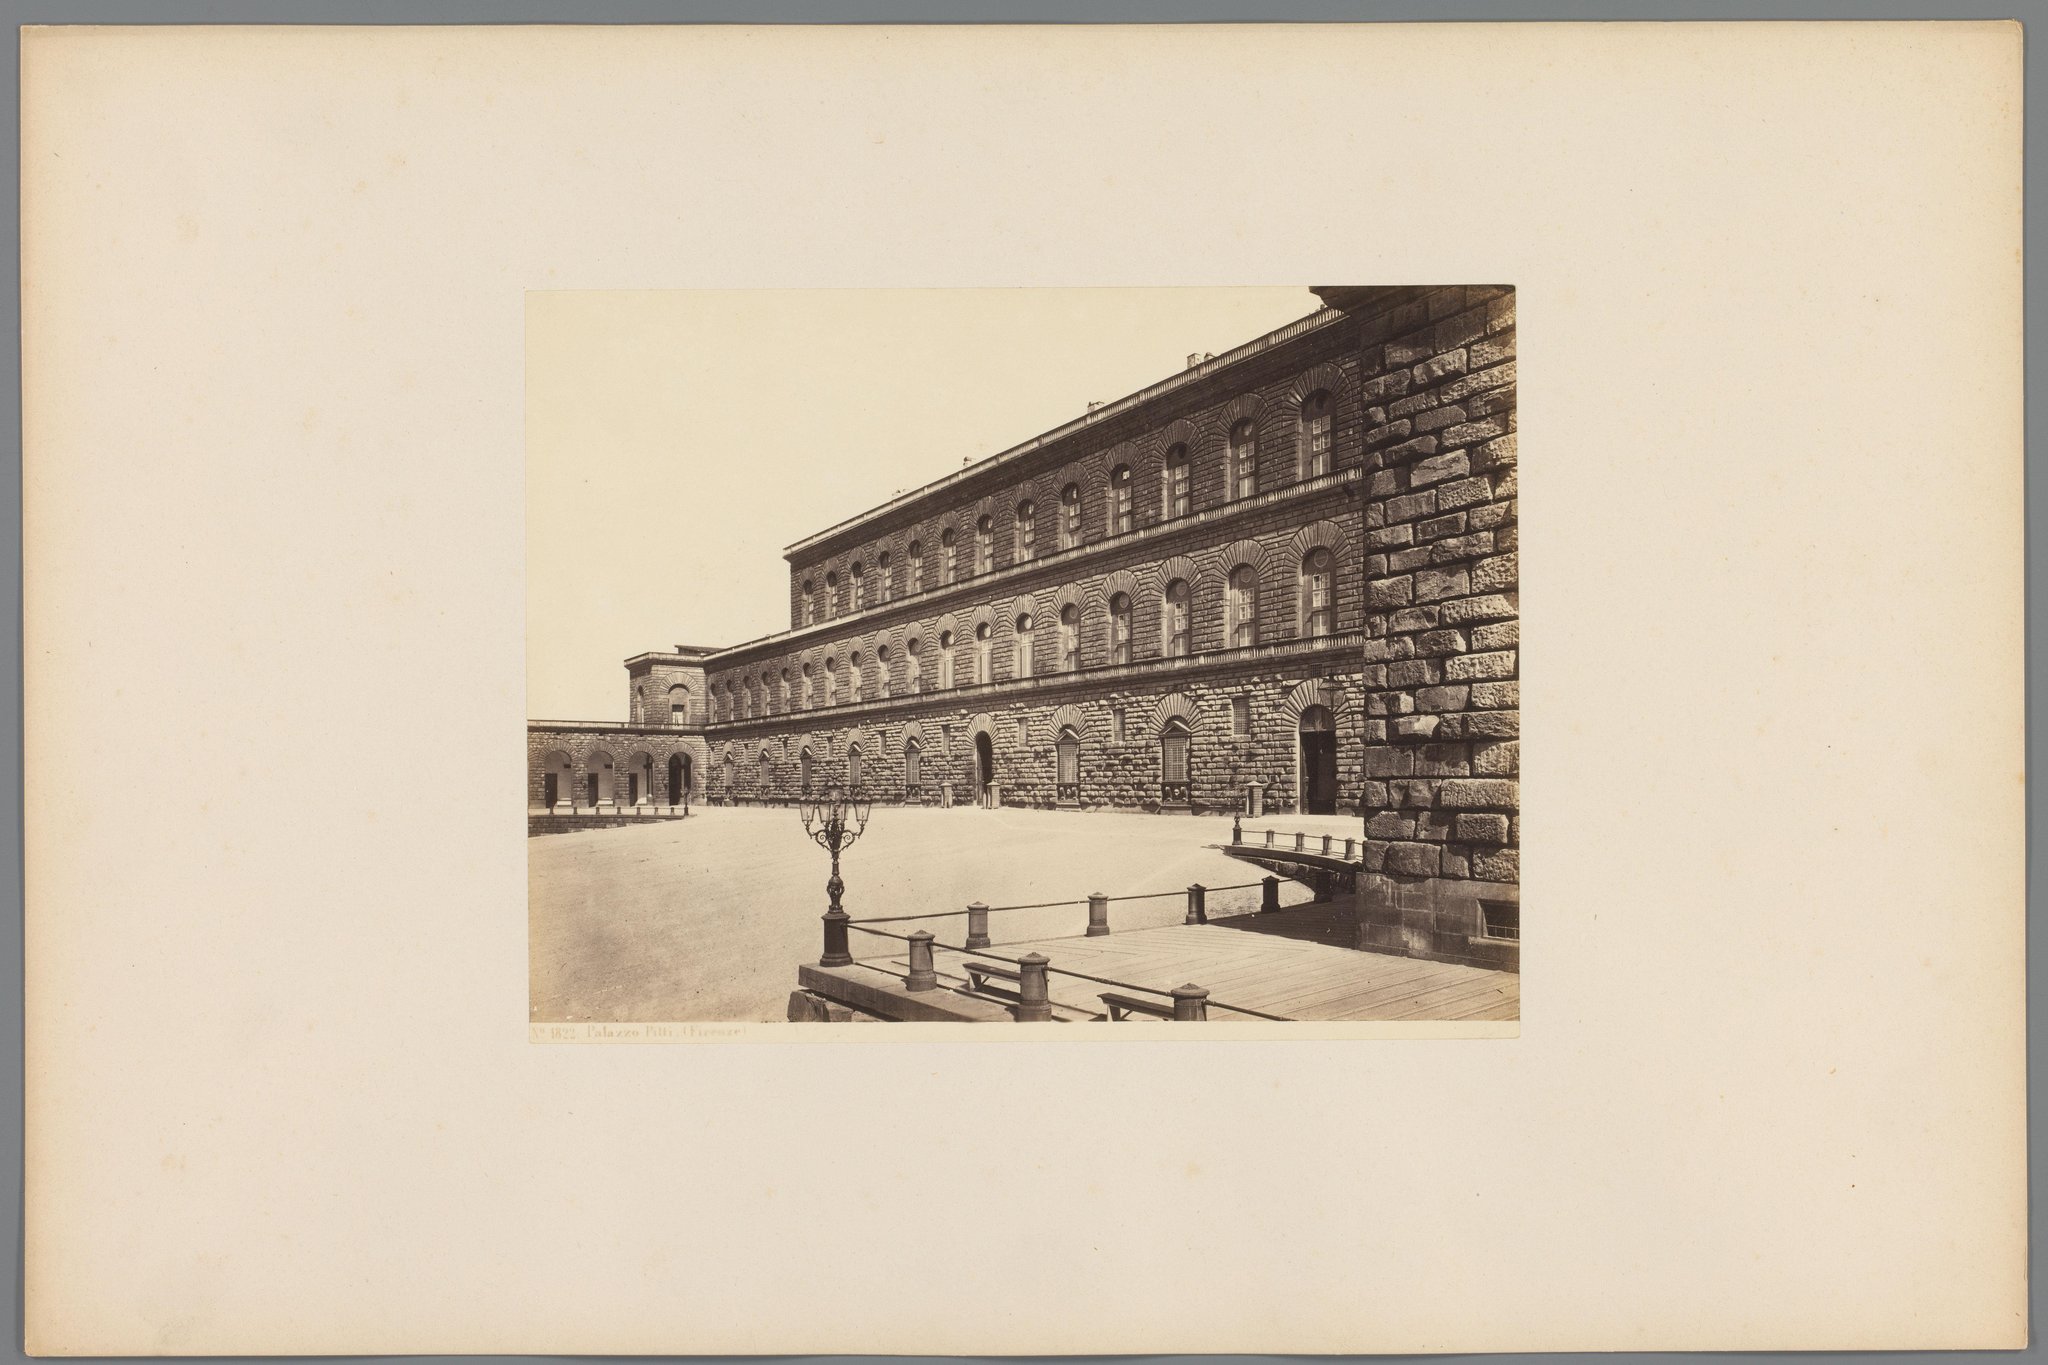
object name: photograph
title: Palazzo Pitti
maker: Anonymous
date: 1851-1900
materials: cardboard, paper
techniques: albumen print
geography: florence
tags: hôtel, i.e. small palace in city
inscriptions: number: ‘No. 1822’